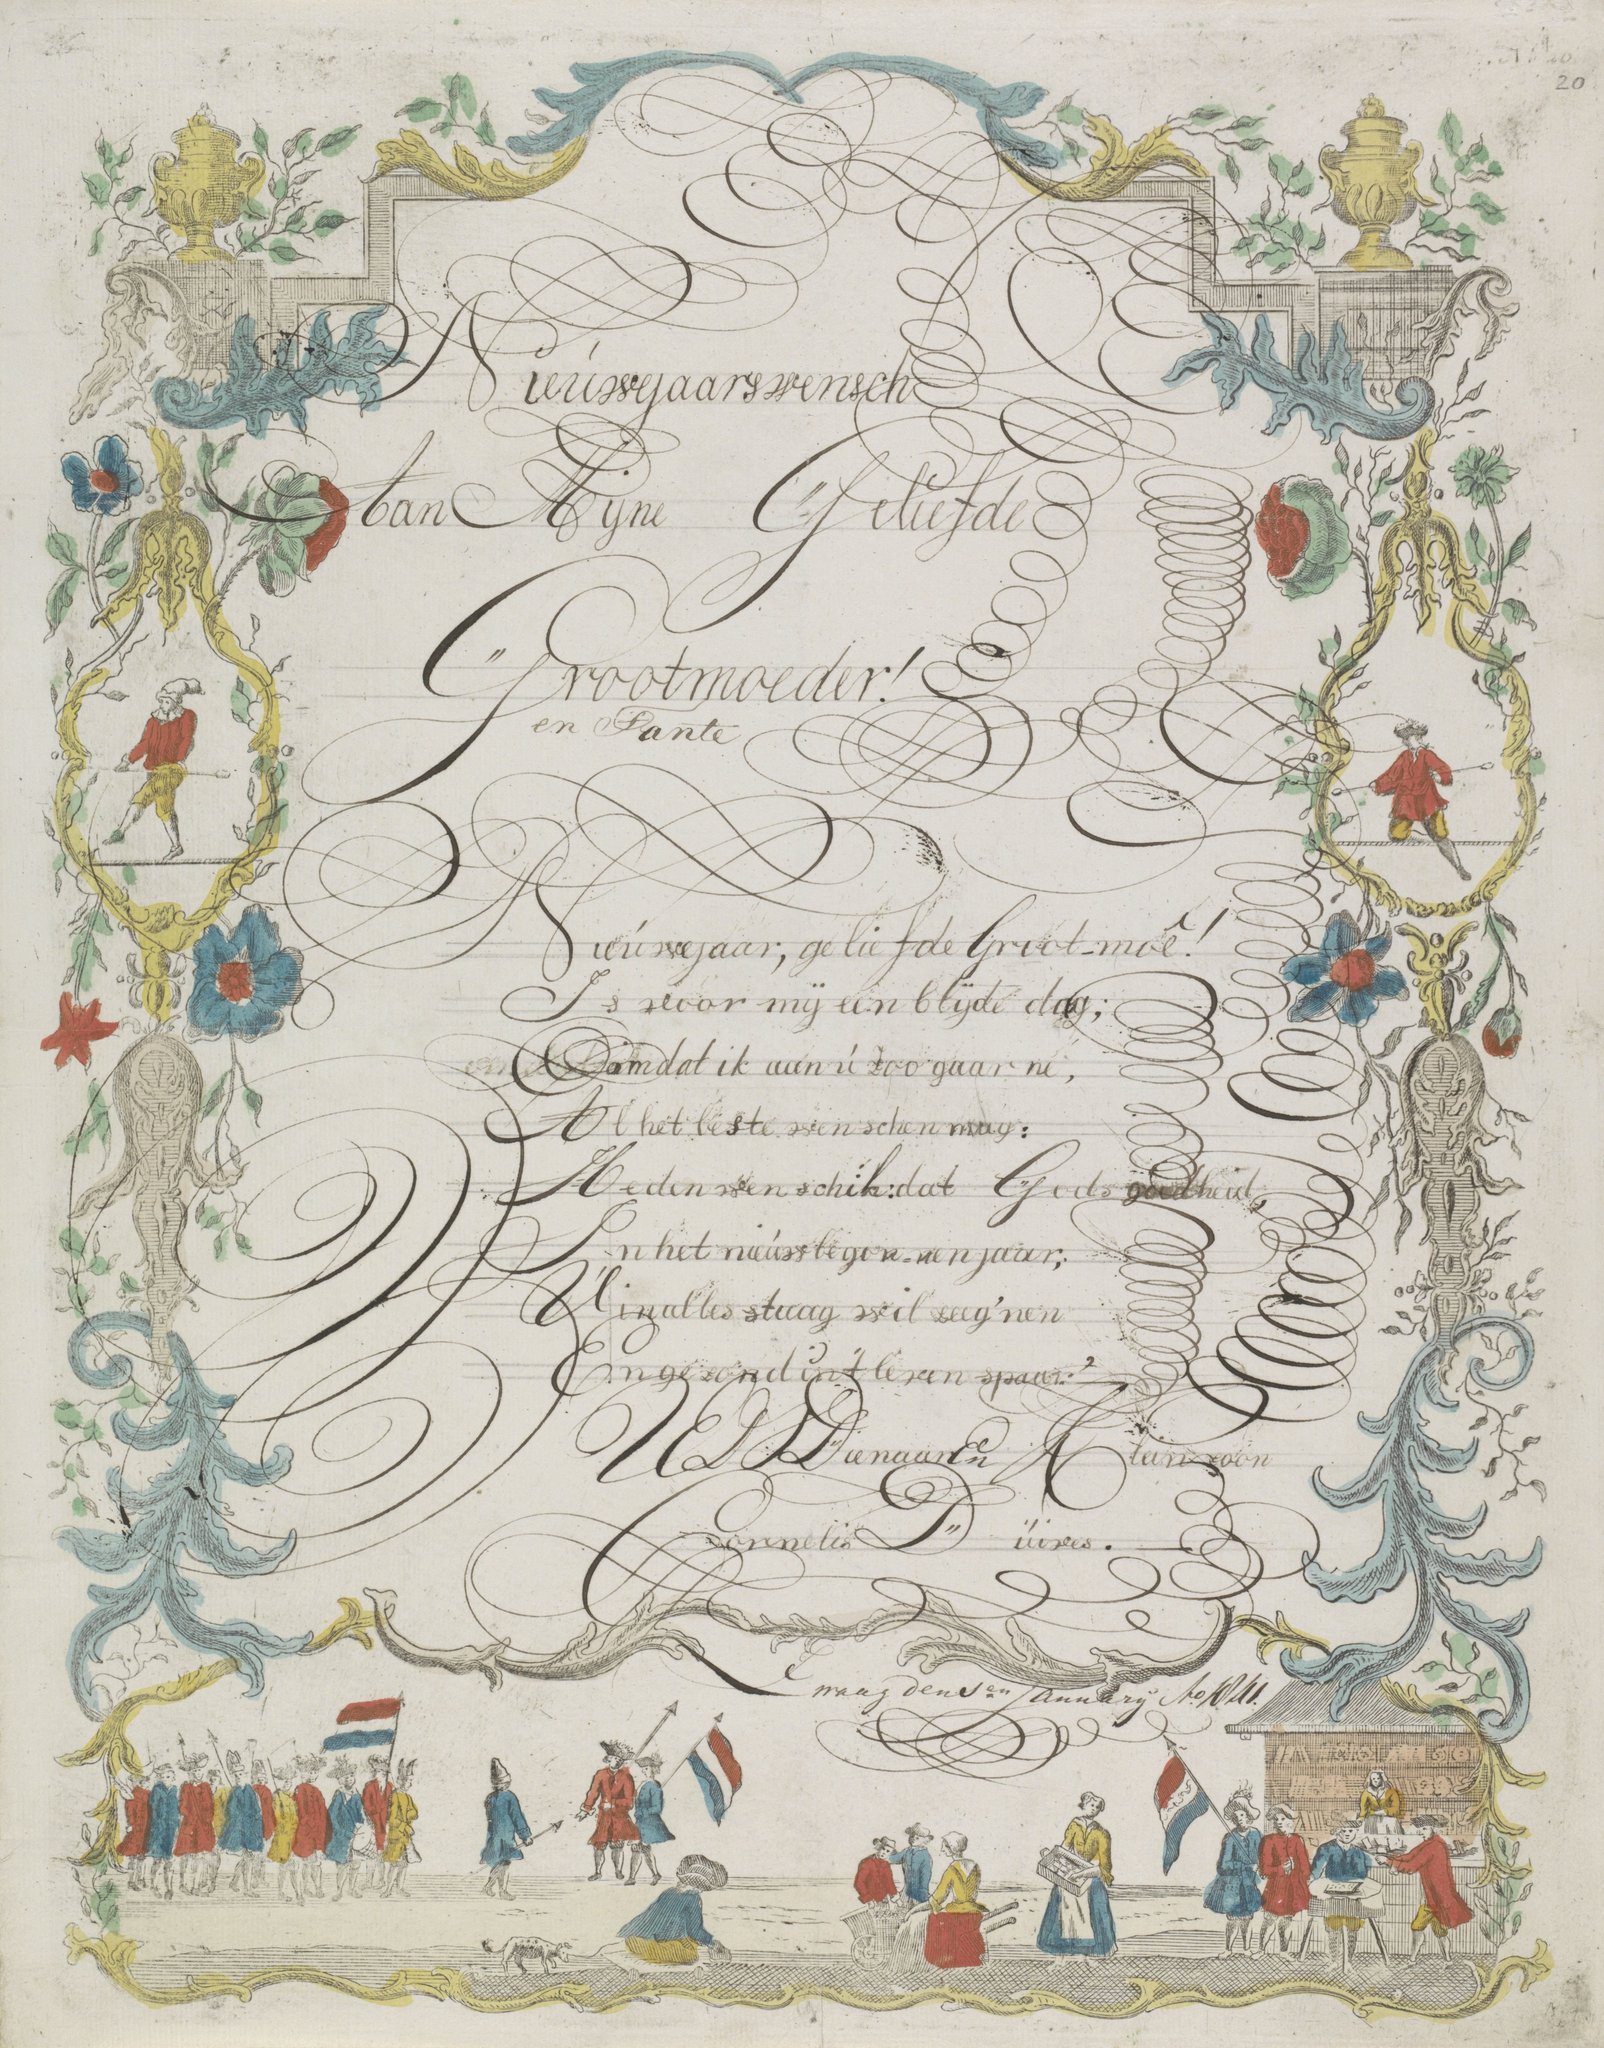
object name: print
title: Wensbrief met koorddansers en de schutterij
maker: Anonymous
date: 1841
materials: ink, paper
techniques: calligraphy, colour, etching, pen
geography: netherlands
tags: equilibrist, warfare; military affairs (+ citizen soldiery, civil guard, citizen militia)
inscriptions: inscription: ‘Nieuwejaarswensch / aan mijne geliefde / grootmoeder! / en tante / Nieuwejaar, geliefde grootmoê! ...’, collector's mark: Lugt 2760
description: Wensbrief met beschreven cartouche binnen een decoratief kader met voorstellingen van koorddansers en van het optrekken van de schutterij. Handgeschreven bericht in kalligrafie (nieuwjaarswens) door Cornelis Duivis aan zijn grootmoeder en tante. Genummerd rechtsboven: N. 26 en daaronder, in potlood: 20.